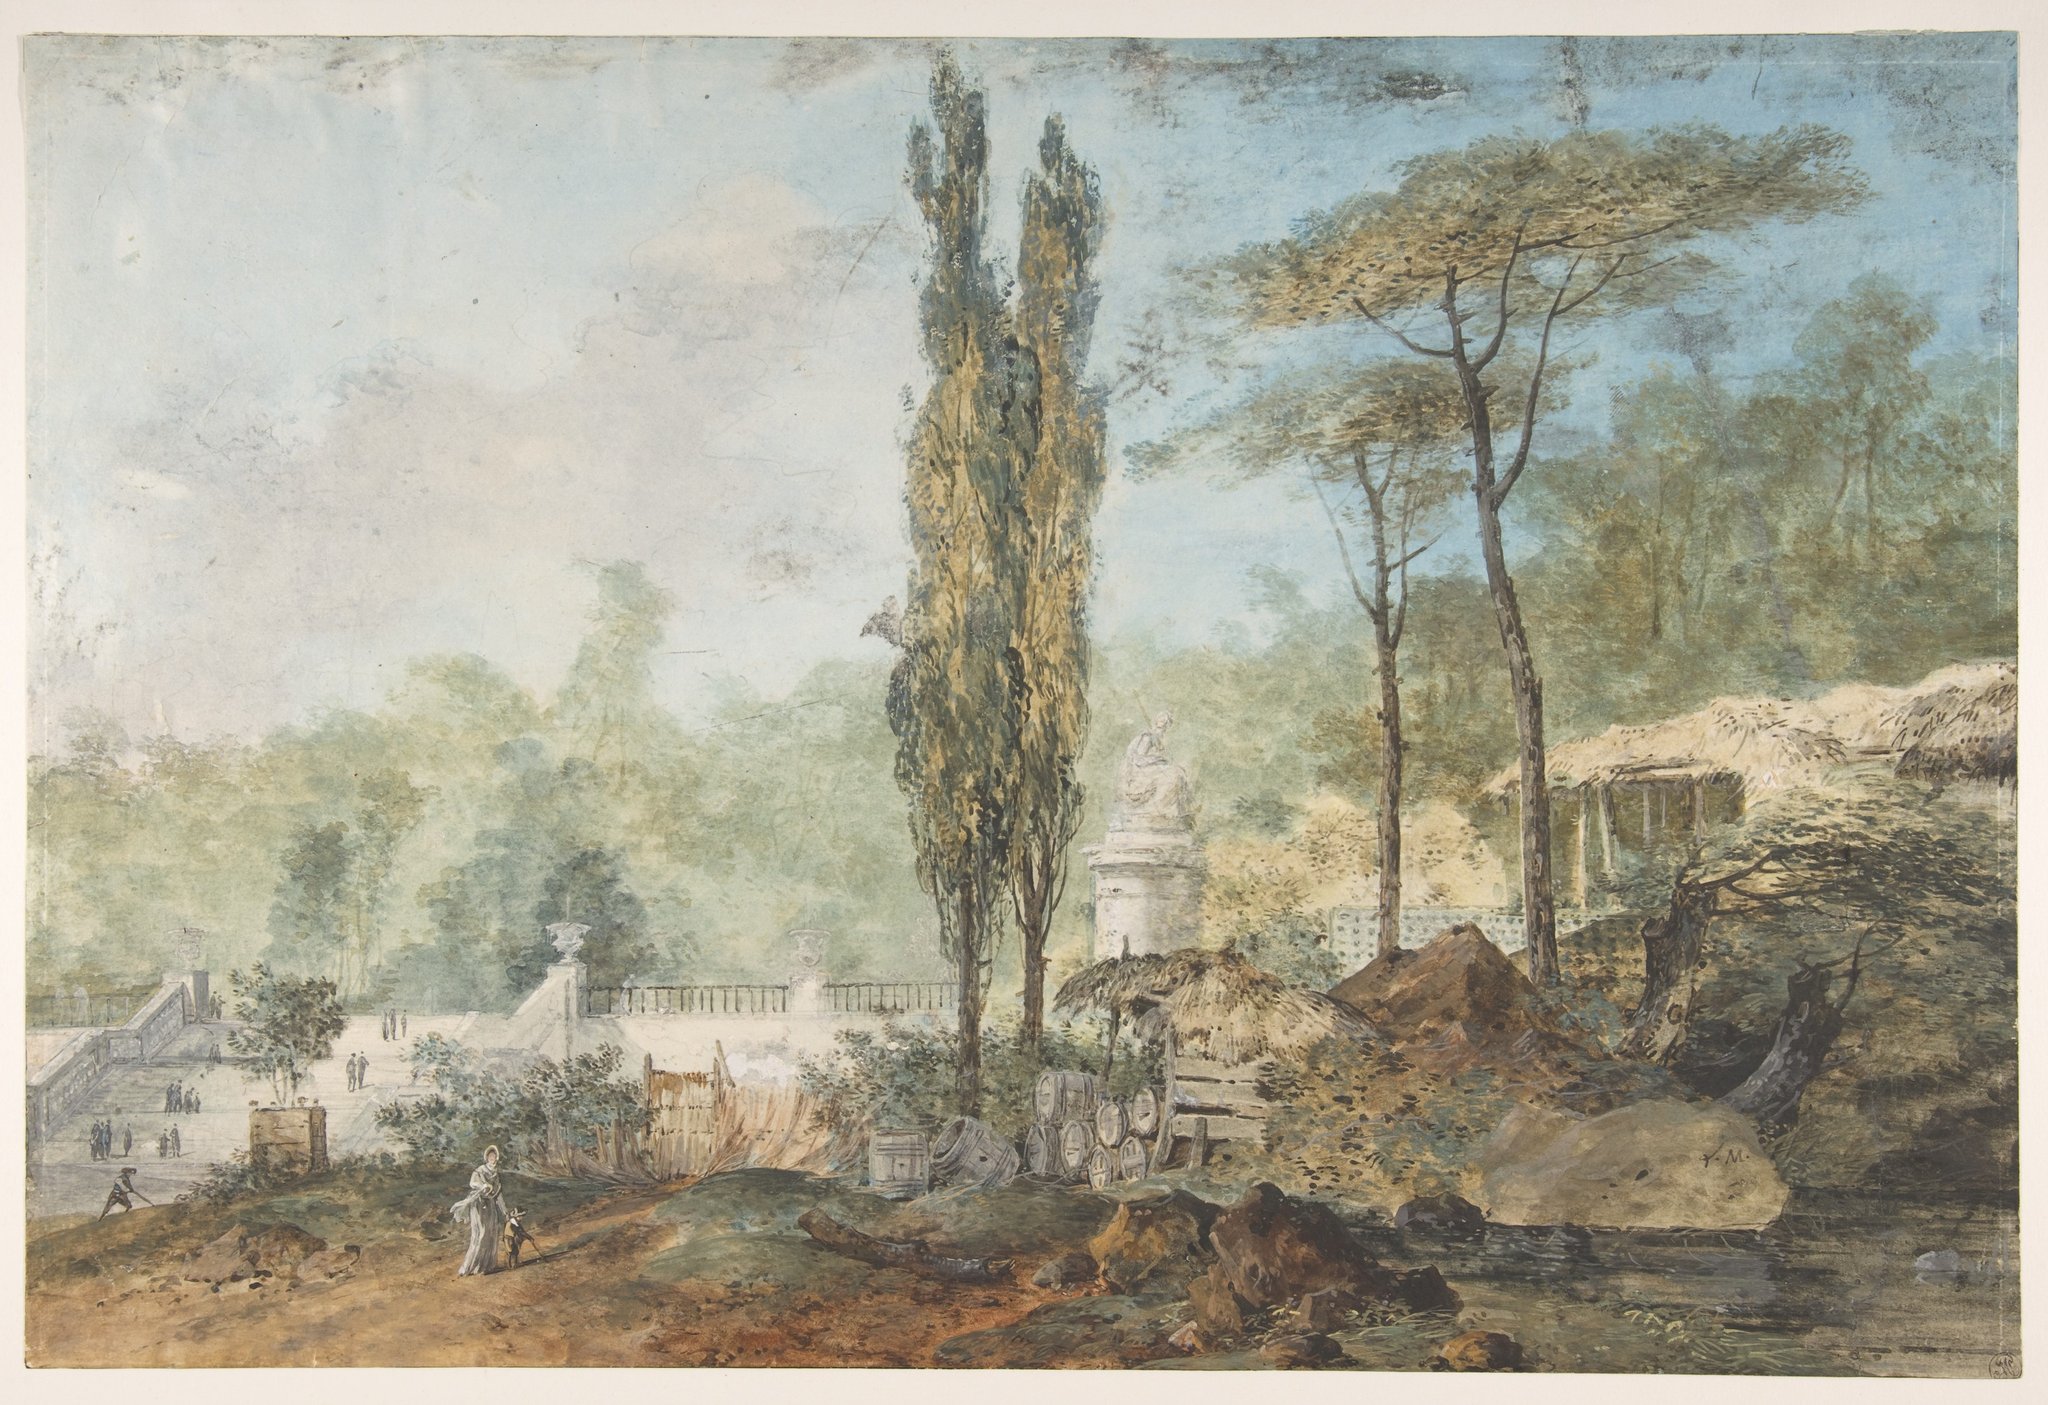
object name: drawing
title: View of a Park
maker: louis gabriel moreau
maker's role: artist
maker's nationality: french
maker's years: 1740-1806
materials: gouache, graphite, watercolor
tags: human figures,parks,trees